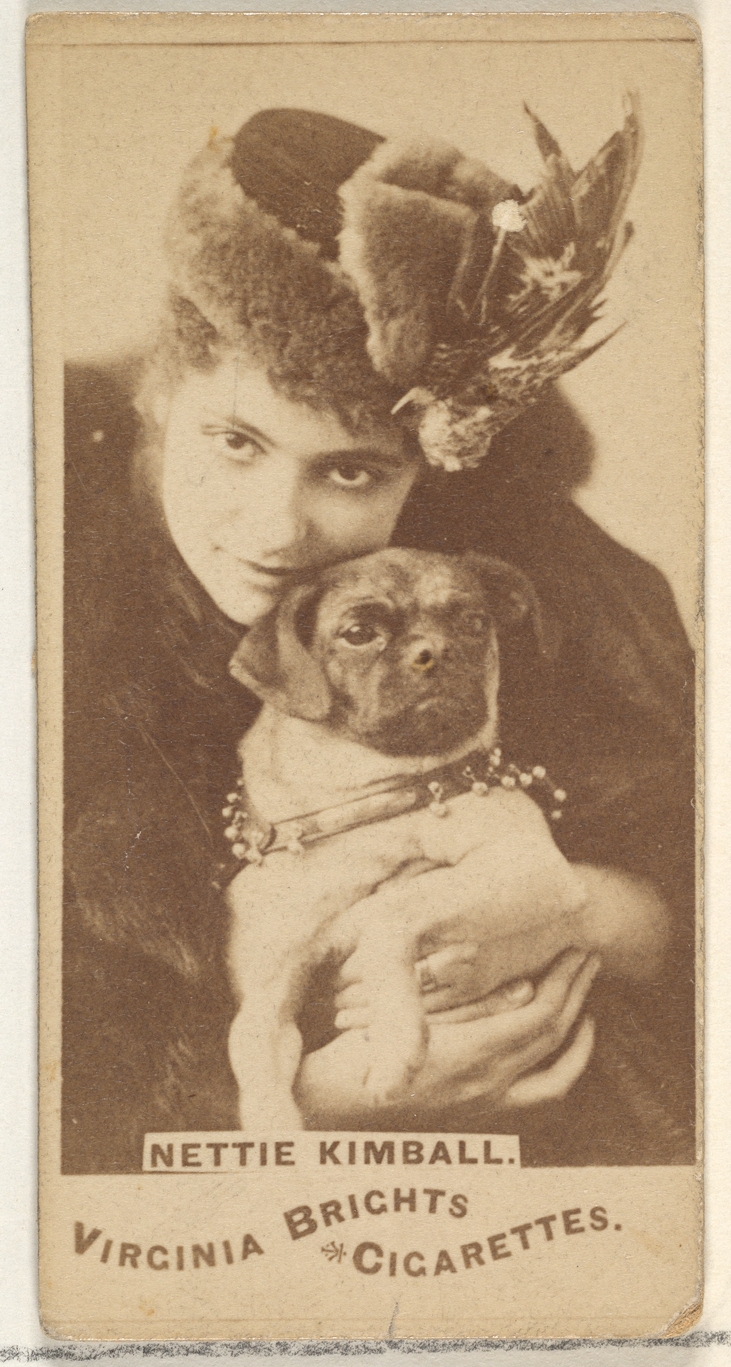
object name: photograph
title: Nettie Kimball, from the Actors and Actresses series (N45, Type 1) for Virginia Brights Cigarettes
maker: allen & ginter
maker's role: publisher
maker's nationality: american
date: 1888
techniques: albumen silver print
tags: portraits,women,dogs,actresses